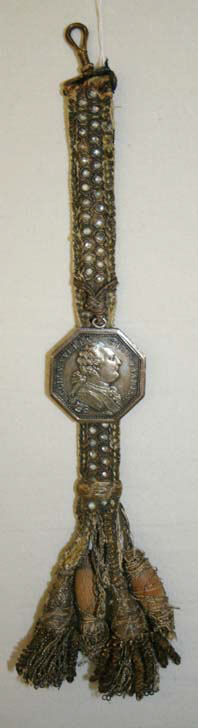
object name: fob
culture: french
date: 1701-1800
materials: linen, metal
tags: men